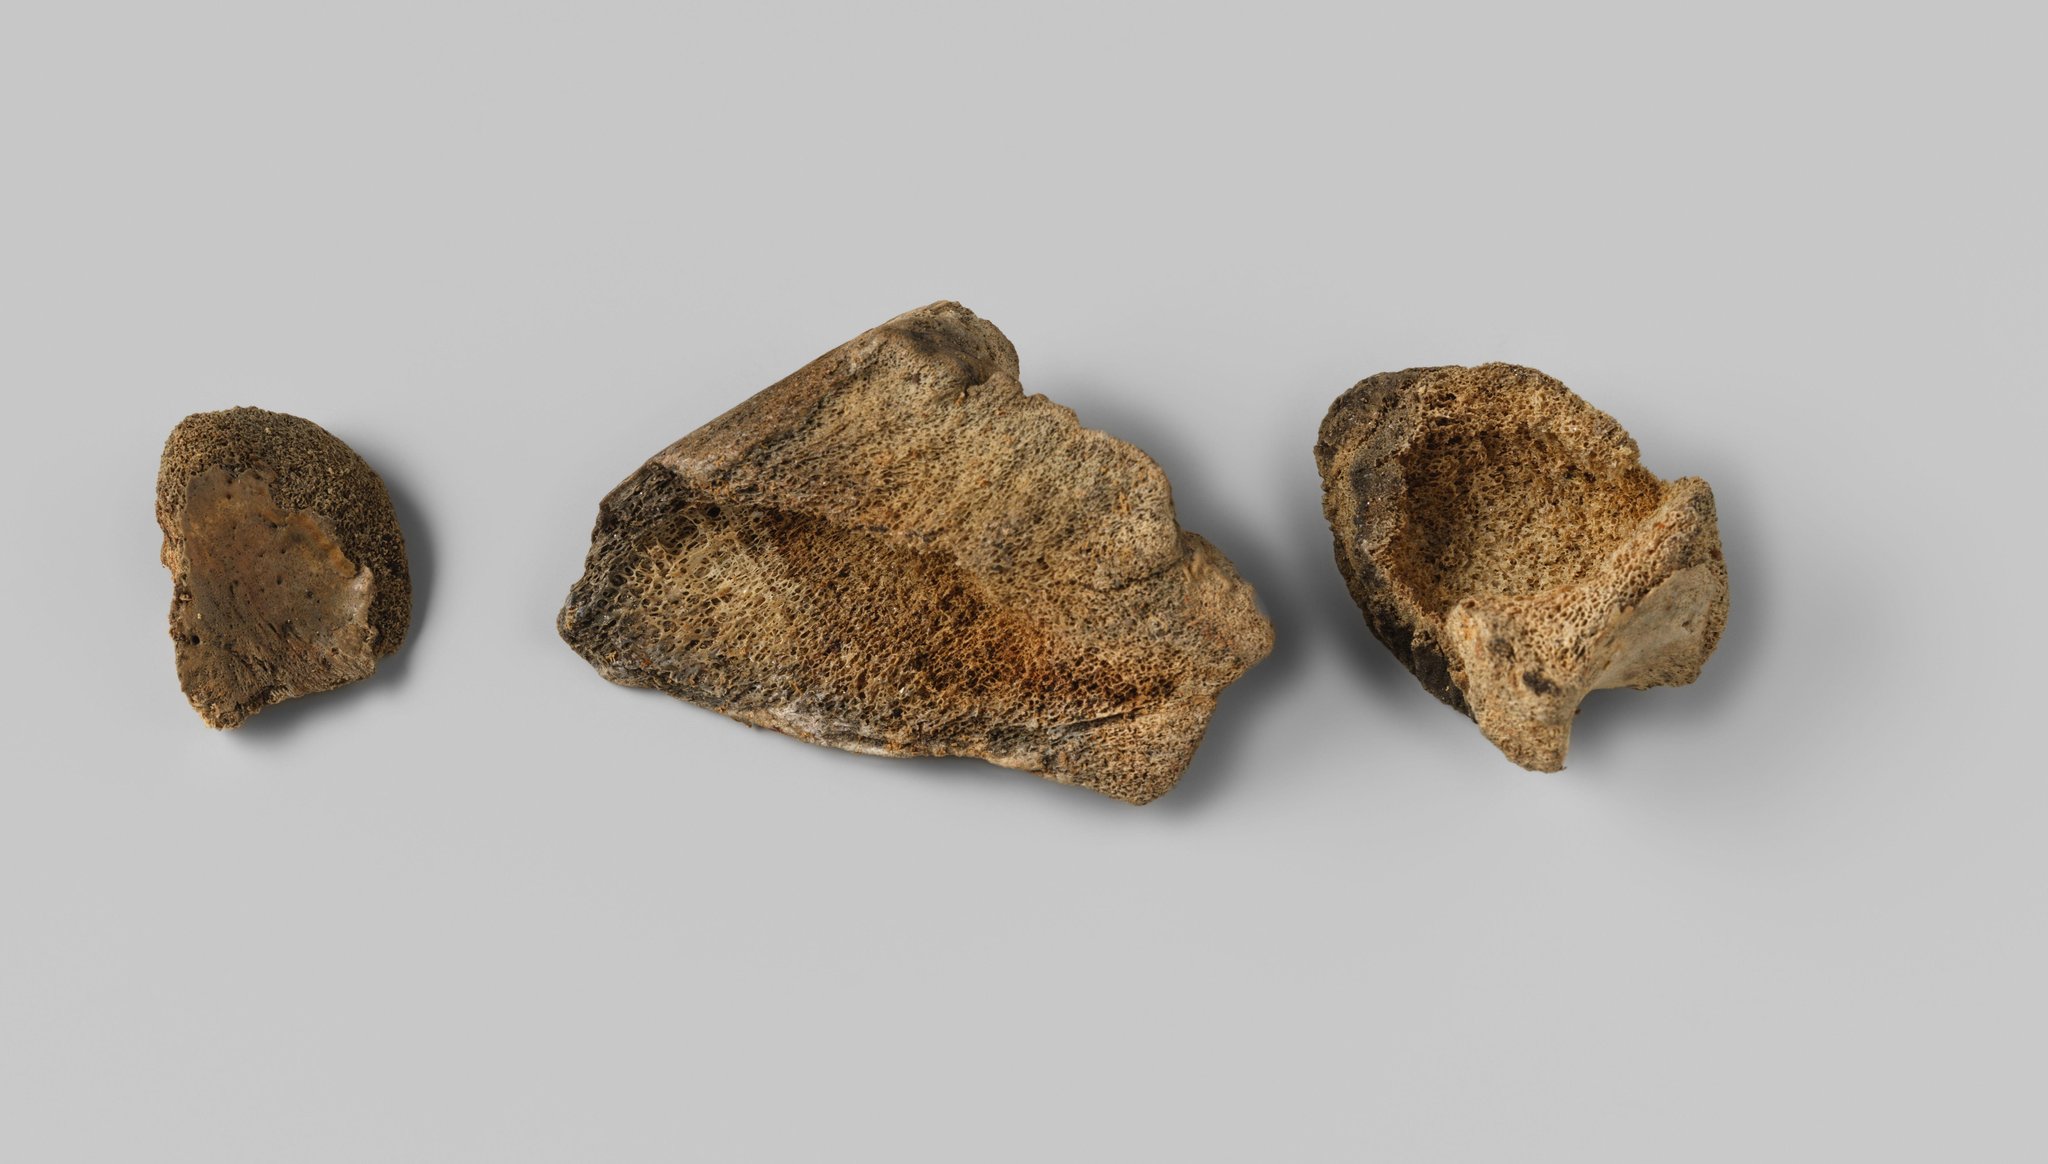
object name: bone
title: Fragmenten bot uit het wrak van de Oostindiëvaarder Hollandia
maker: Anonymous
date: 1700-1743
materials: bone